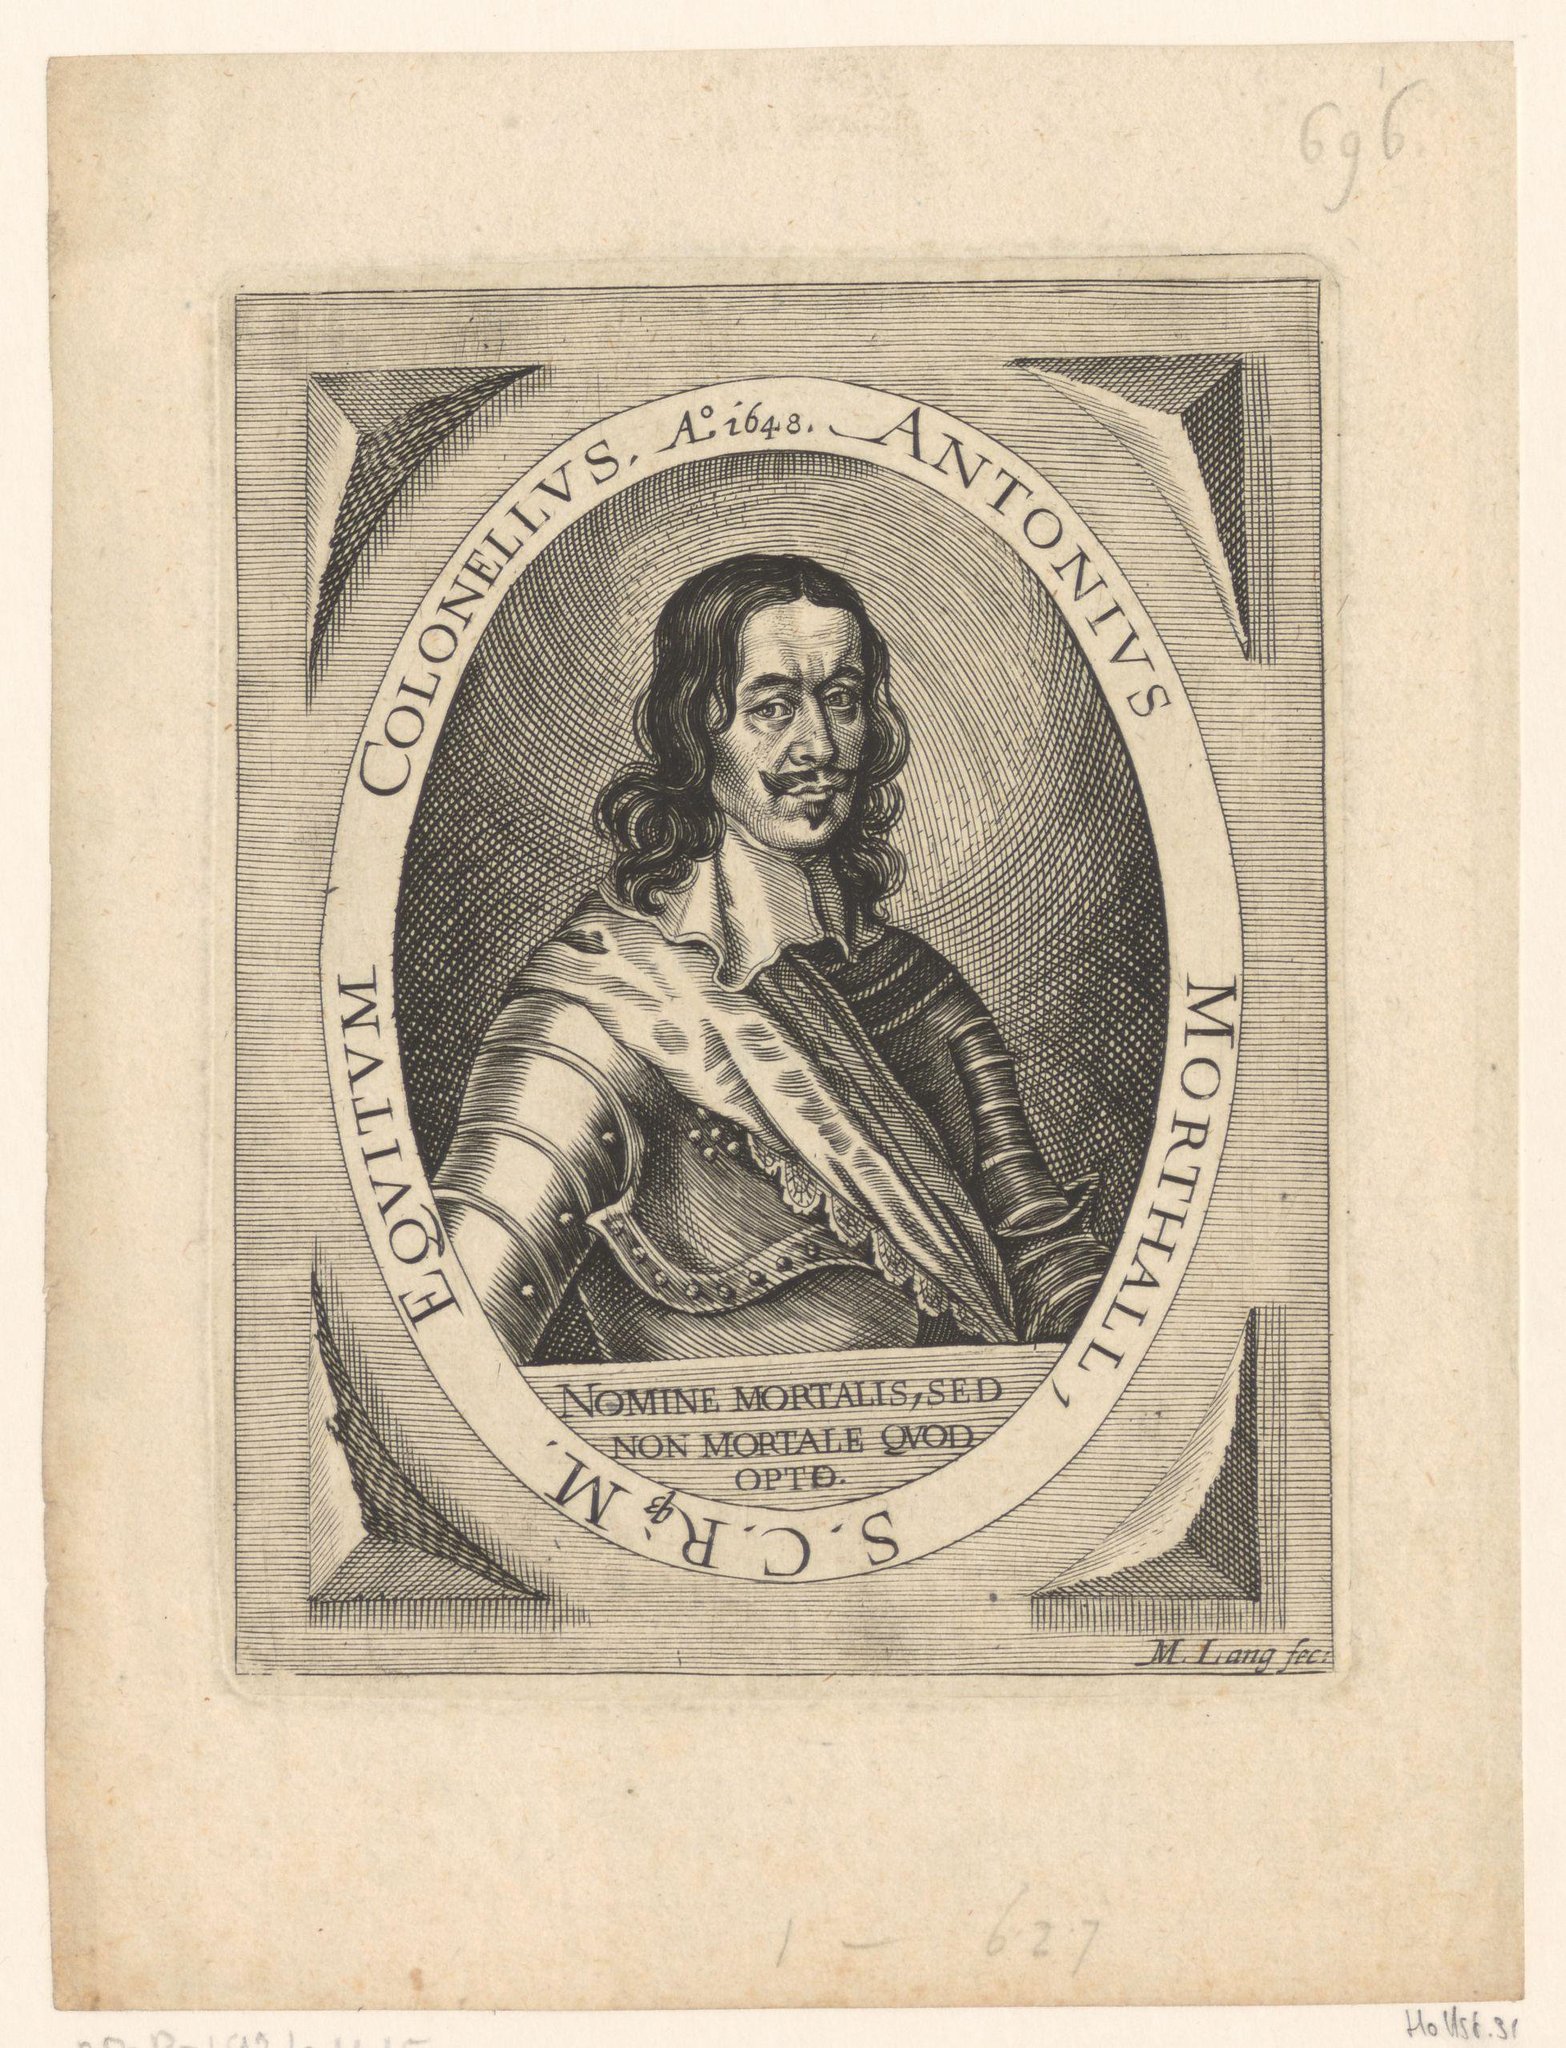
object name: print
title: Portret van Anton Morthall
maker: moritz lang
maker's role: draughtsman, print maker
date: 1646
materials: paper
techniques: engraving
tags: commander-in-chief, general, marshal, historical persons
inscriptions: collector's mark: Lugt 2233